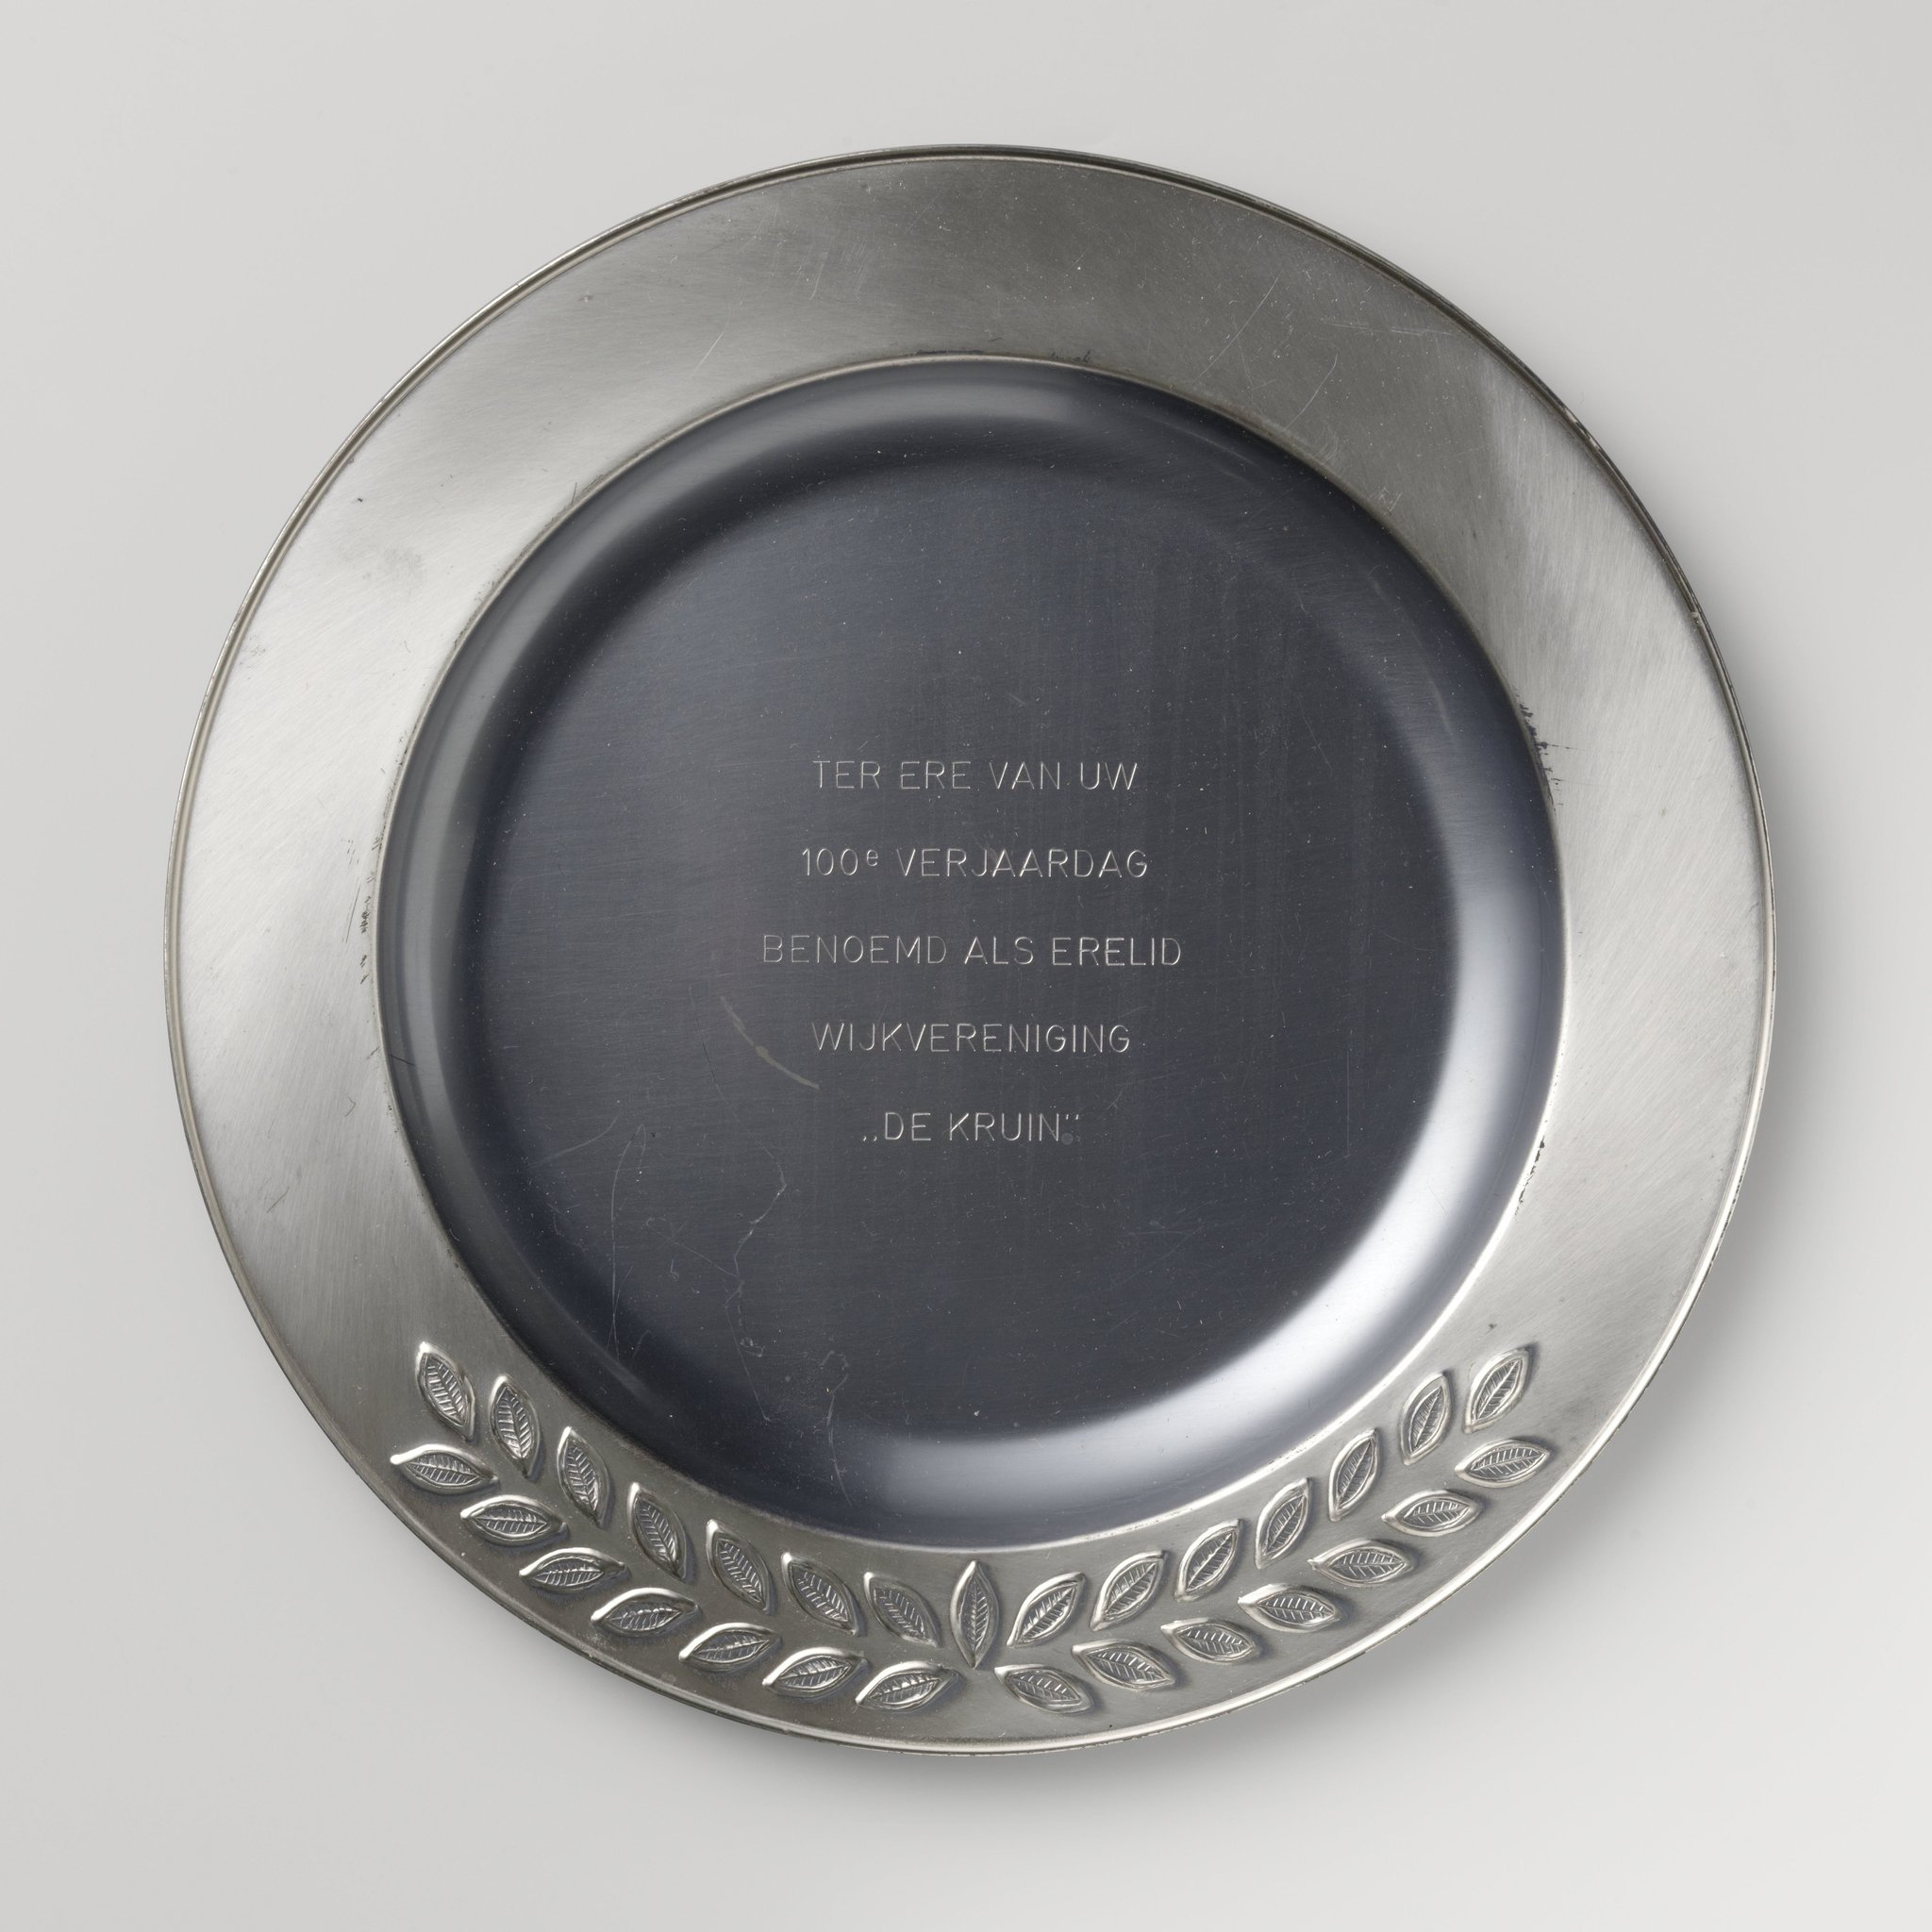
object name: wandbord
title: Tinnen wandbord ter ere van het erelidmaatschap dat Drees op zijn 100e verjaardag ontvangt van wijkvereniging De Kruin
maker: hvb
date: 1986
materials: tin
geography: netherlands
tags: amsterdam, the hague, willem drees, netherlands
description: Tinnen wandbord waarvan de rand metaalkleurig is en het middengedeelte dofzwart. Inscriptie: 'Ter ere van uw 100e verjaardag benoemd als Erelid wijkvereniging "De Kruin"'. Achterkant: monogram HvB en hangertje.